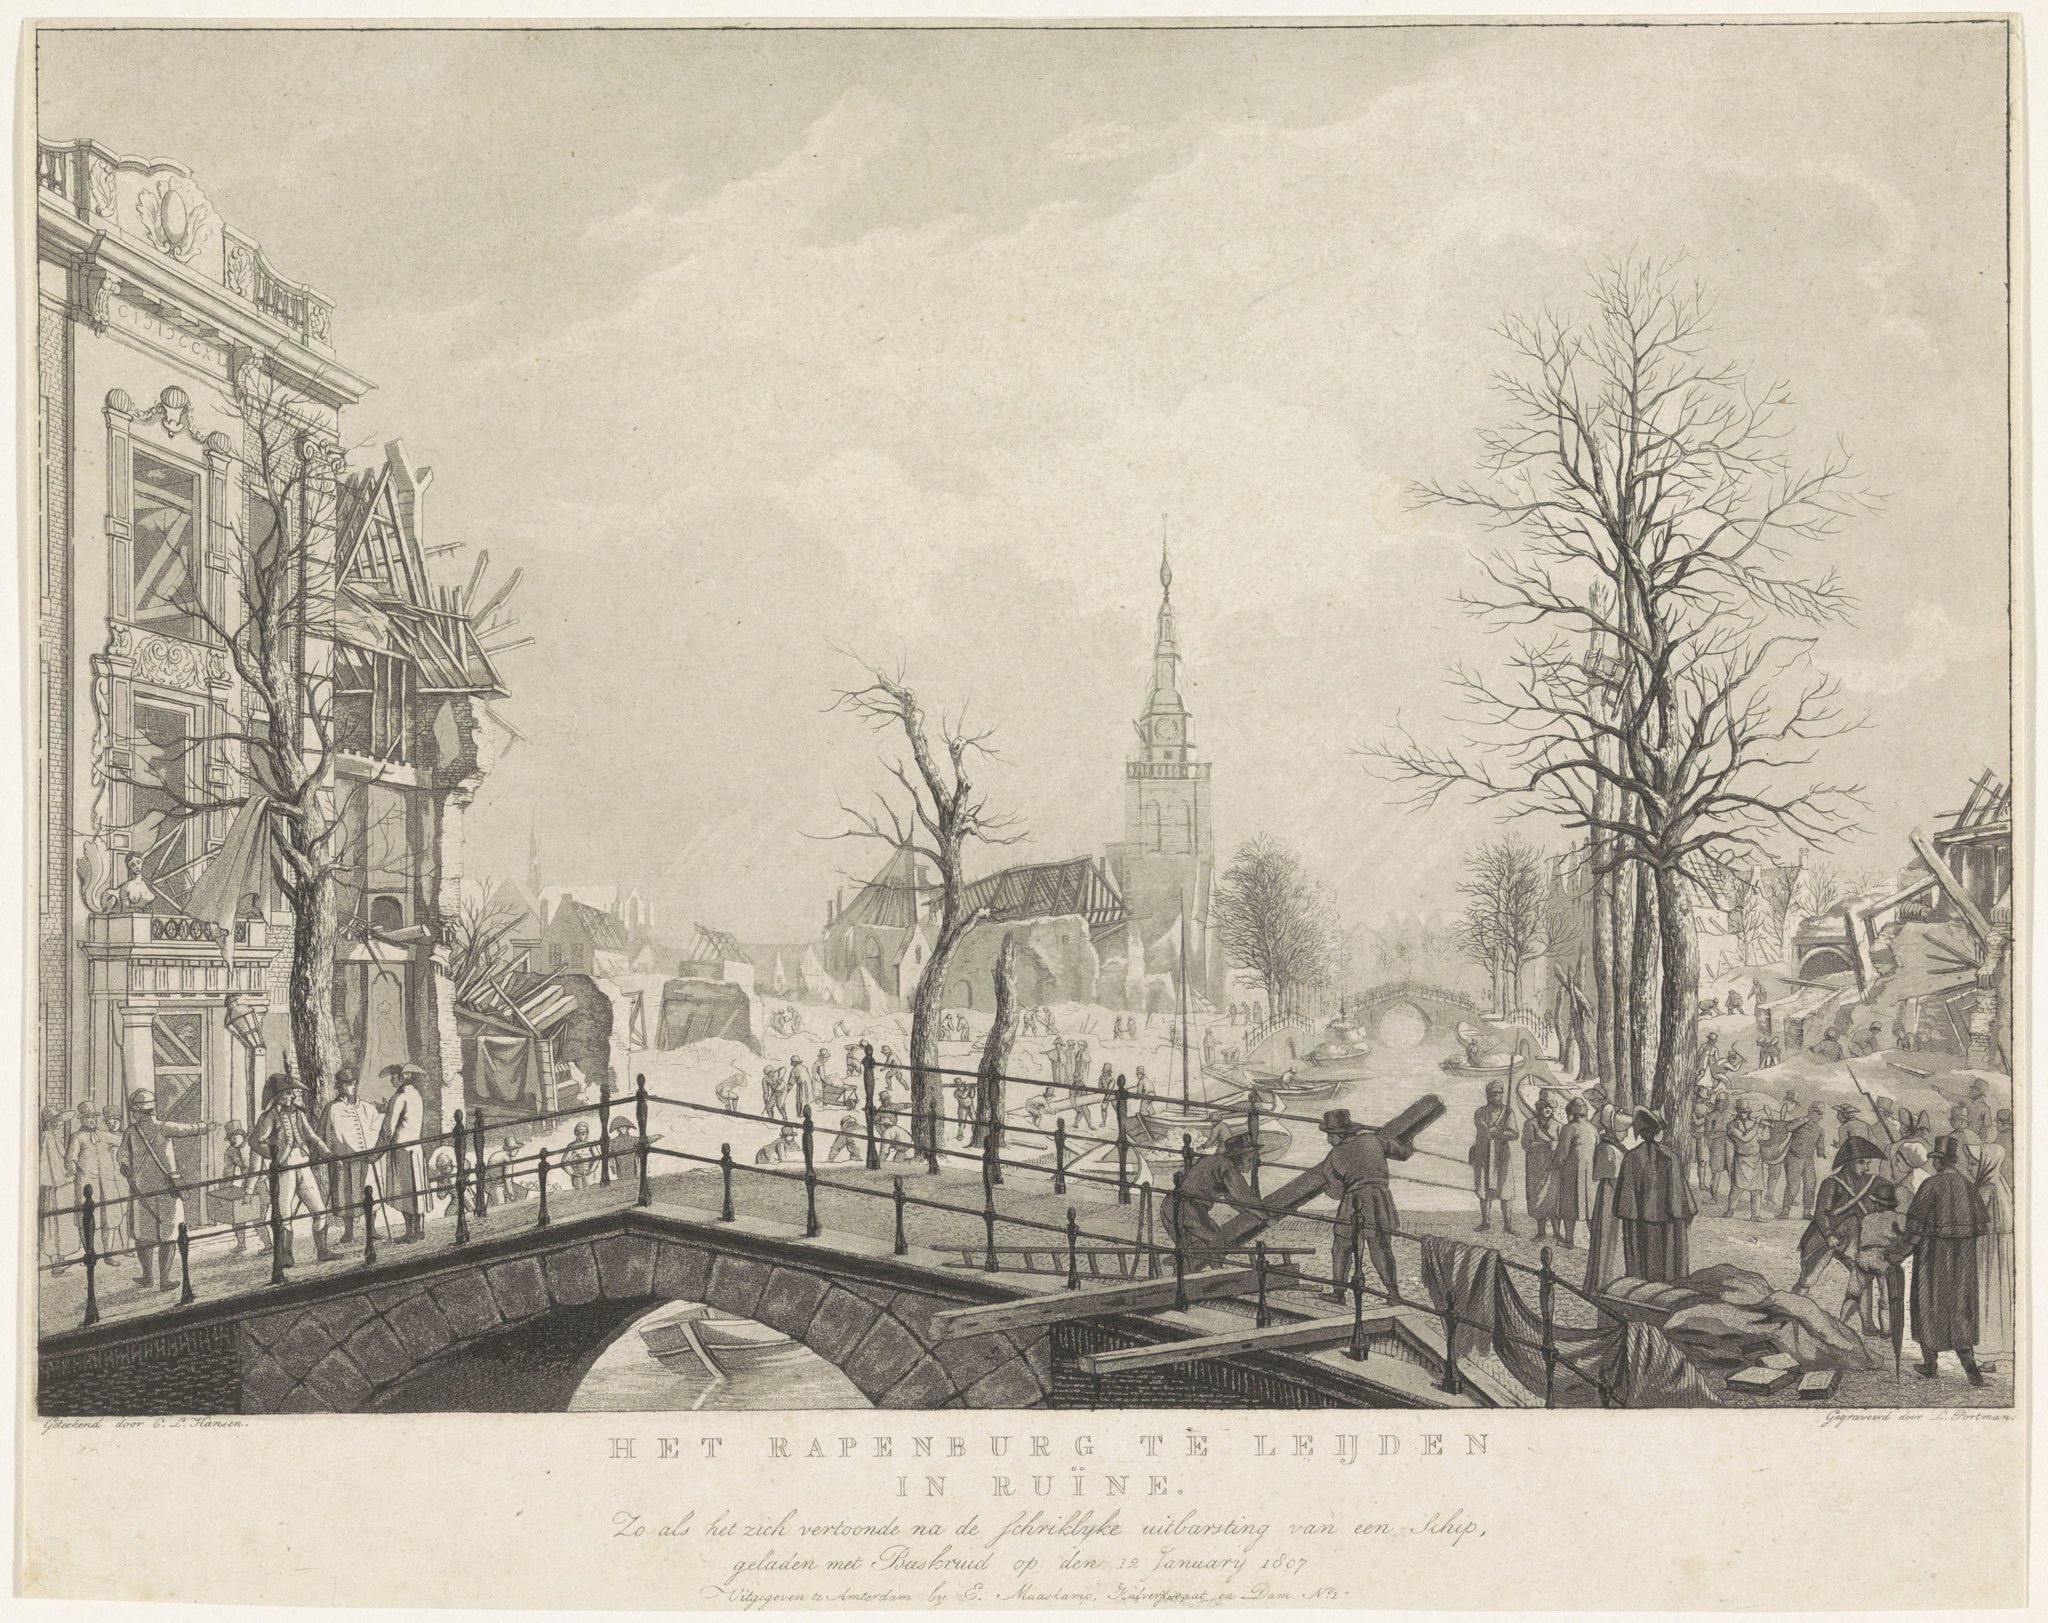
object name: print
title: Ruïnes na de buskruitramp, 1807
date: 1807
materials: paper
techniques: aquatint, etching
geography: amsterdam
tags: gunpowder disaster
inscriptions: collector's mark: Lugt 2228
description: Gezicht vanaf de Nieuwsteegbrug op het verwoest gebied na de buskruitramp op het Steenschuur, een gracht in het verlengde van het Rapenburg, te Leiden op 12 januari 1807. Opruimwerkzaamheden na de ramp, het wegdragen van slachtoffers. Centraal de Saaihal.